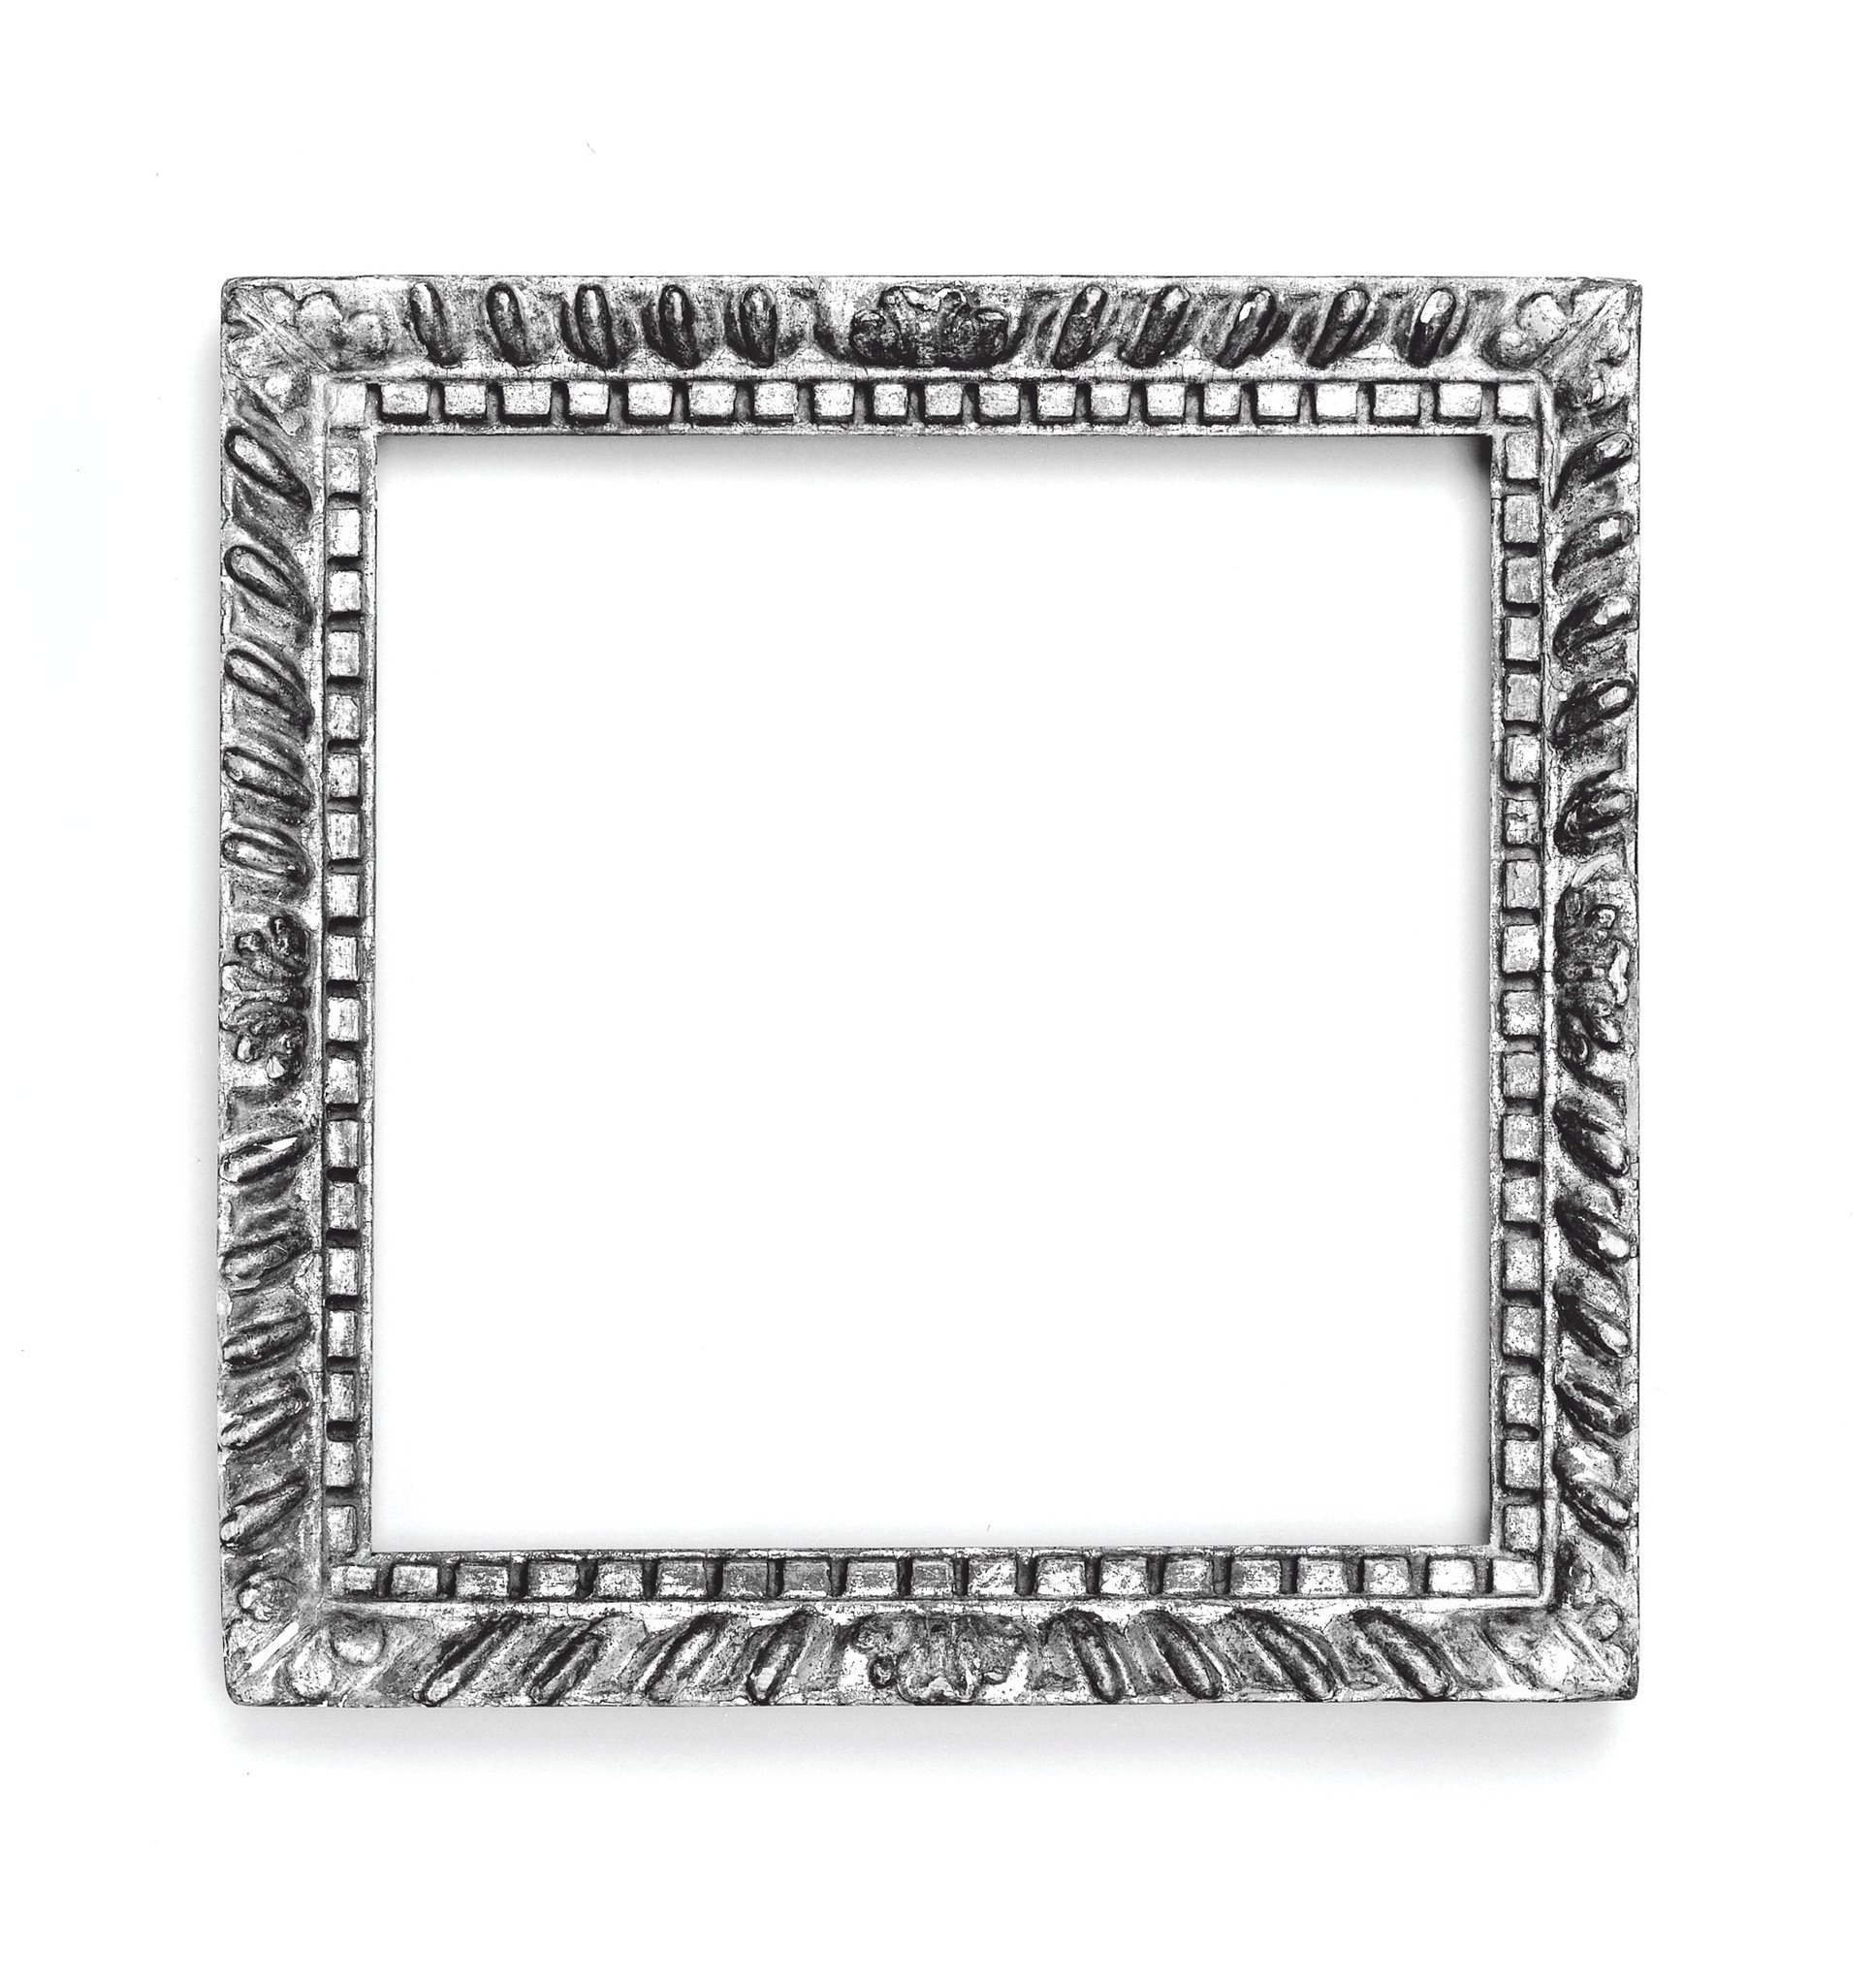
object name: frame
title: Fragment of a cassetta frame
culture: spanish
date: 1567-1600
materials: wood